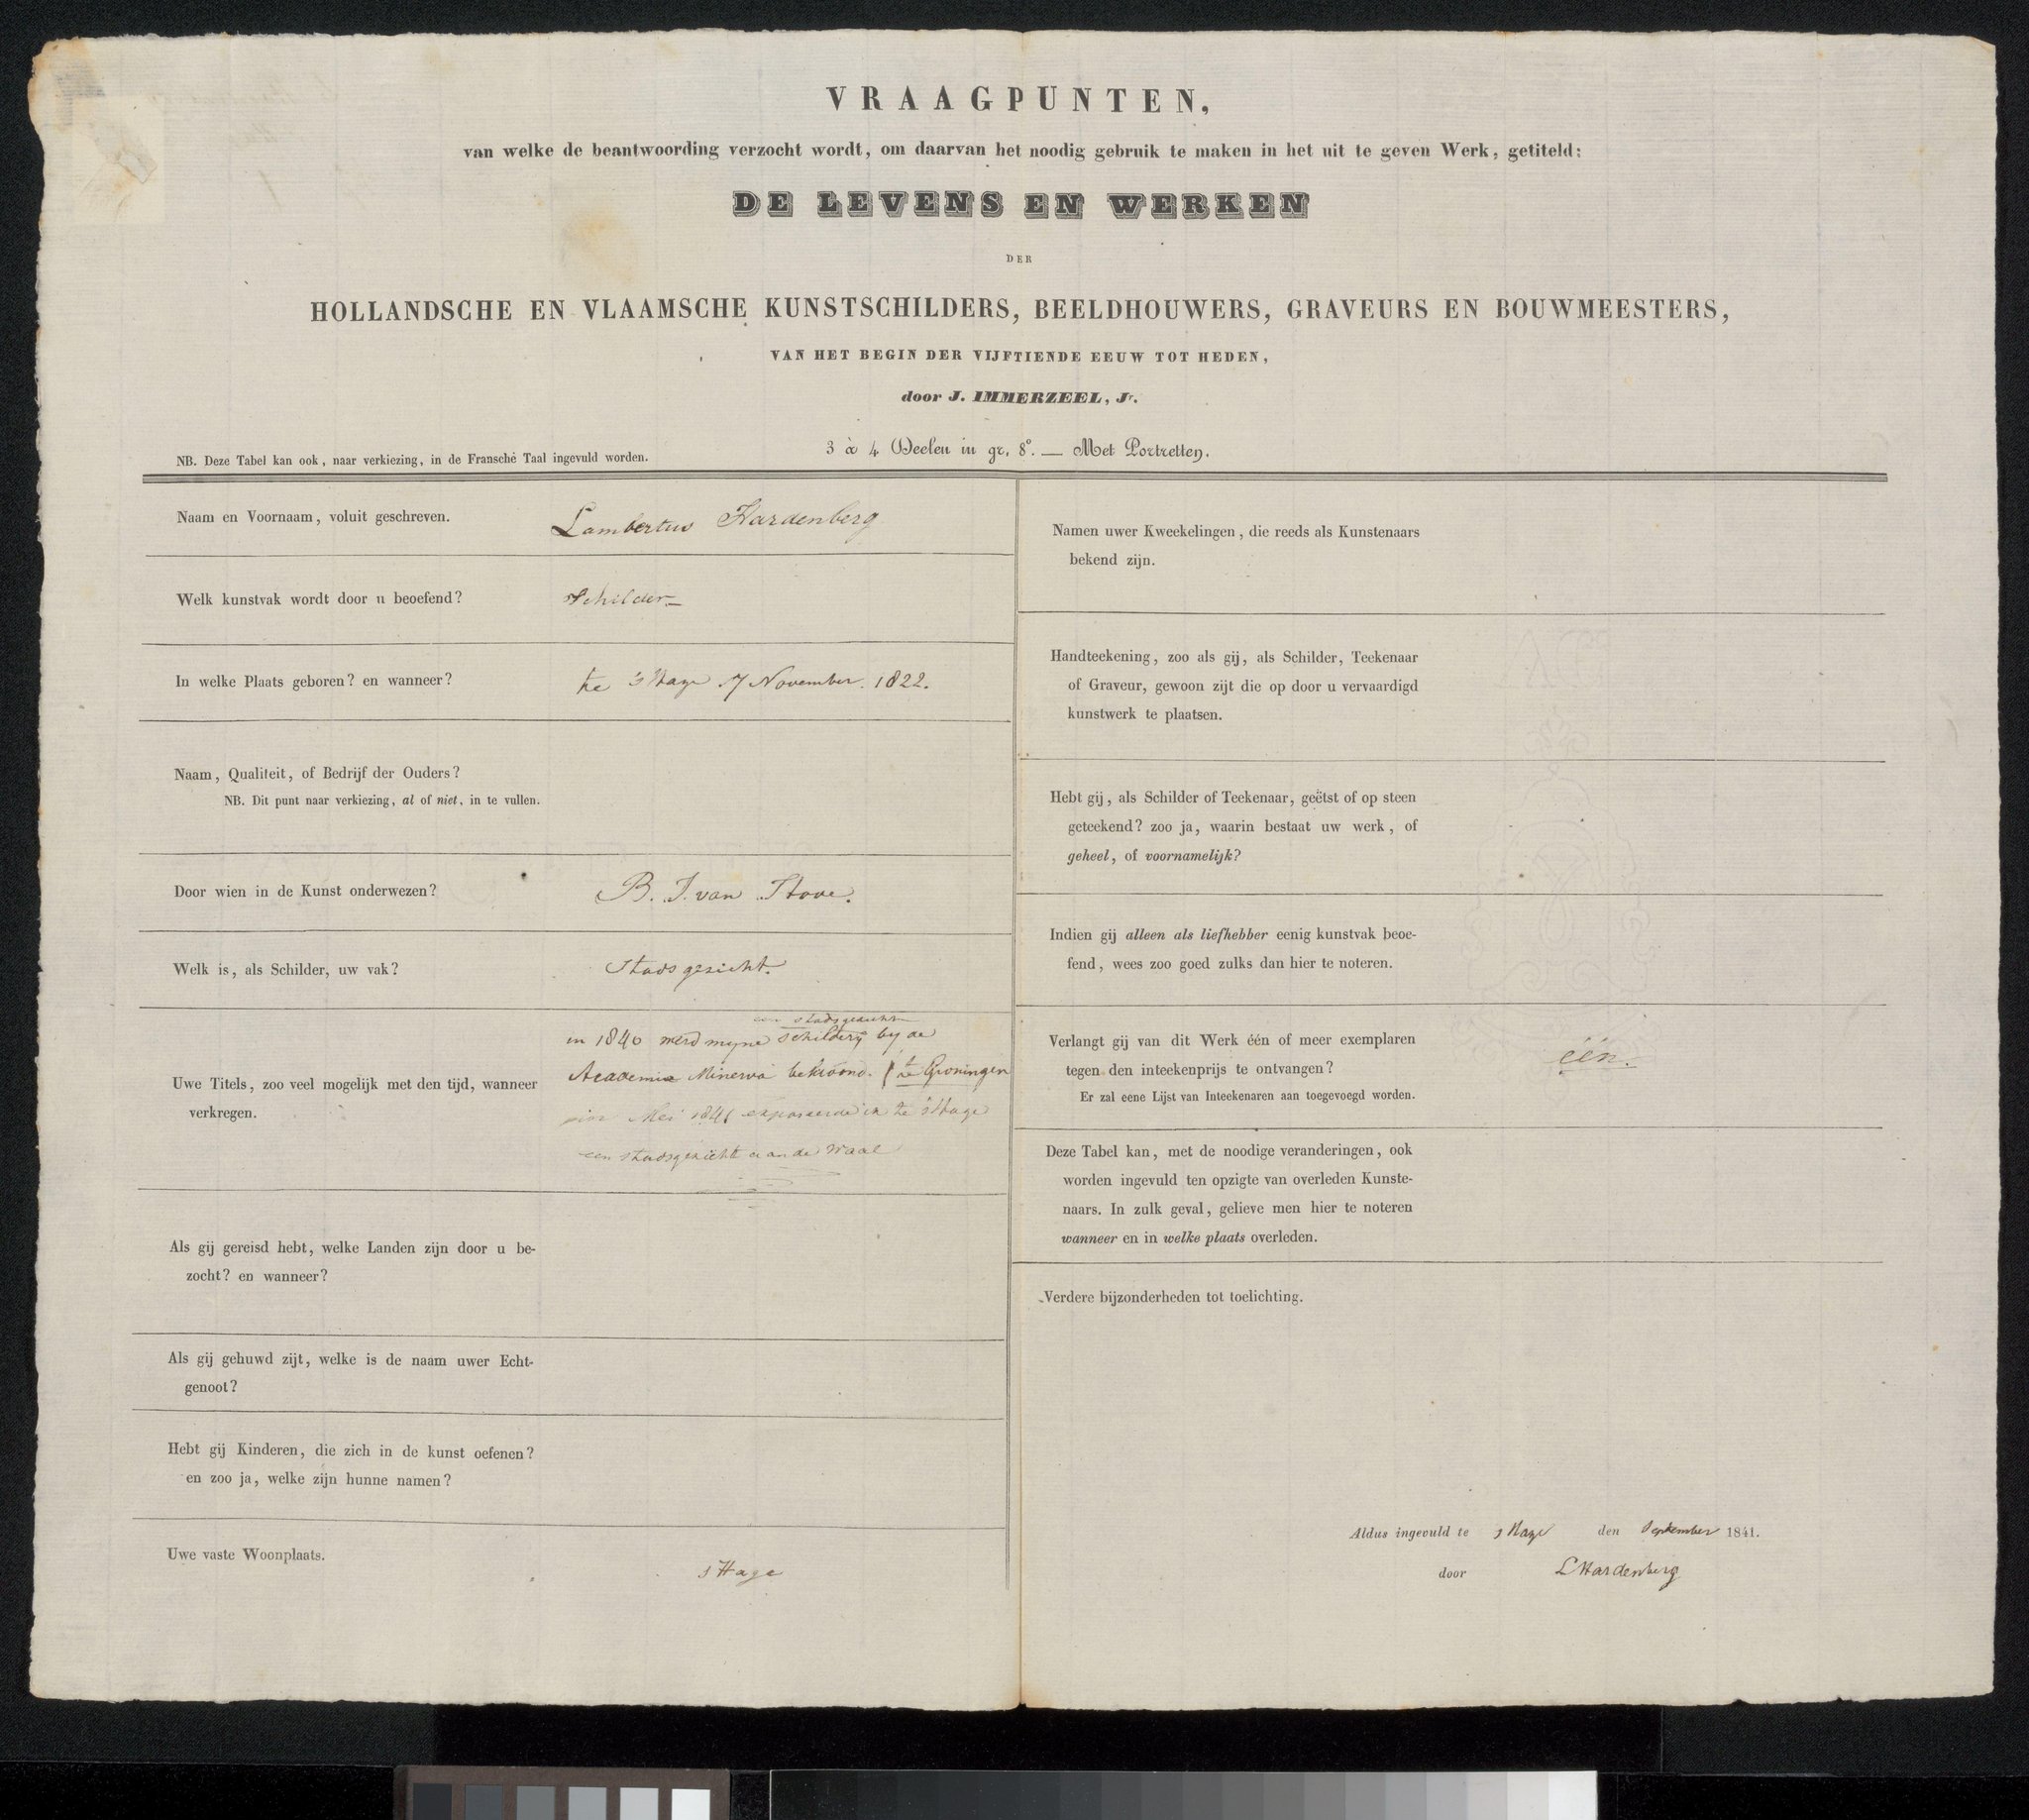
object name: questionnaire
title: Enquêteformulier ingevuld door Lambertus Hardenberg (1822-1900)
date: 1809-1841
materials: ink, paper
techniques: pen, printing, writing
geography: the hague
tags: the hague, painter, print maker, draughtsman, lambertus hardenberg (1822-1900)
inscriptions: inscription: ‘Vraagpunten,/ van welke de beantwoording verzocht wordt, om daarvan het noodig gebruik te maken in het uit te geven Werk, getiteld: De levens en werken/ der Hollandsche en Vlaamsche kunstschilders, beeldhouwers,/ graveurs en bouwmeesters, van het begin der vijftiende eeuw tot heden/ door J. Immerzeel, Jr.’, watermark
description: Opgenomen in: Immerzeel, J. Jr., De levens en werken der Hollandsche en Vlaamsche kunstschilders, beeldhouwers, graveurs en bouwmeesters, van het begin der vijftiende eeuw tot heden, Amsterdam: J.C. van Kesteren, 1842-1843.